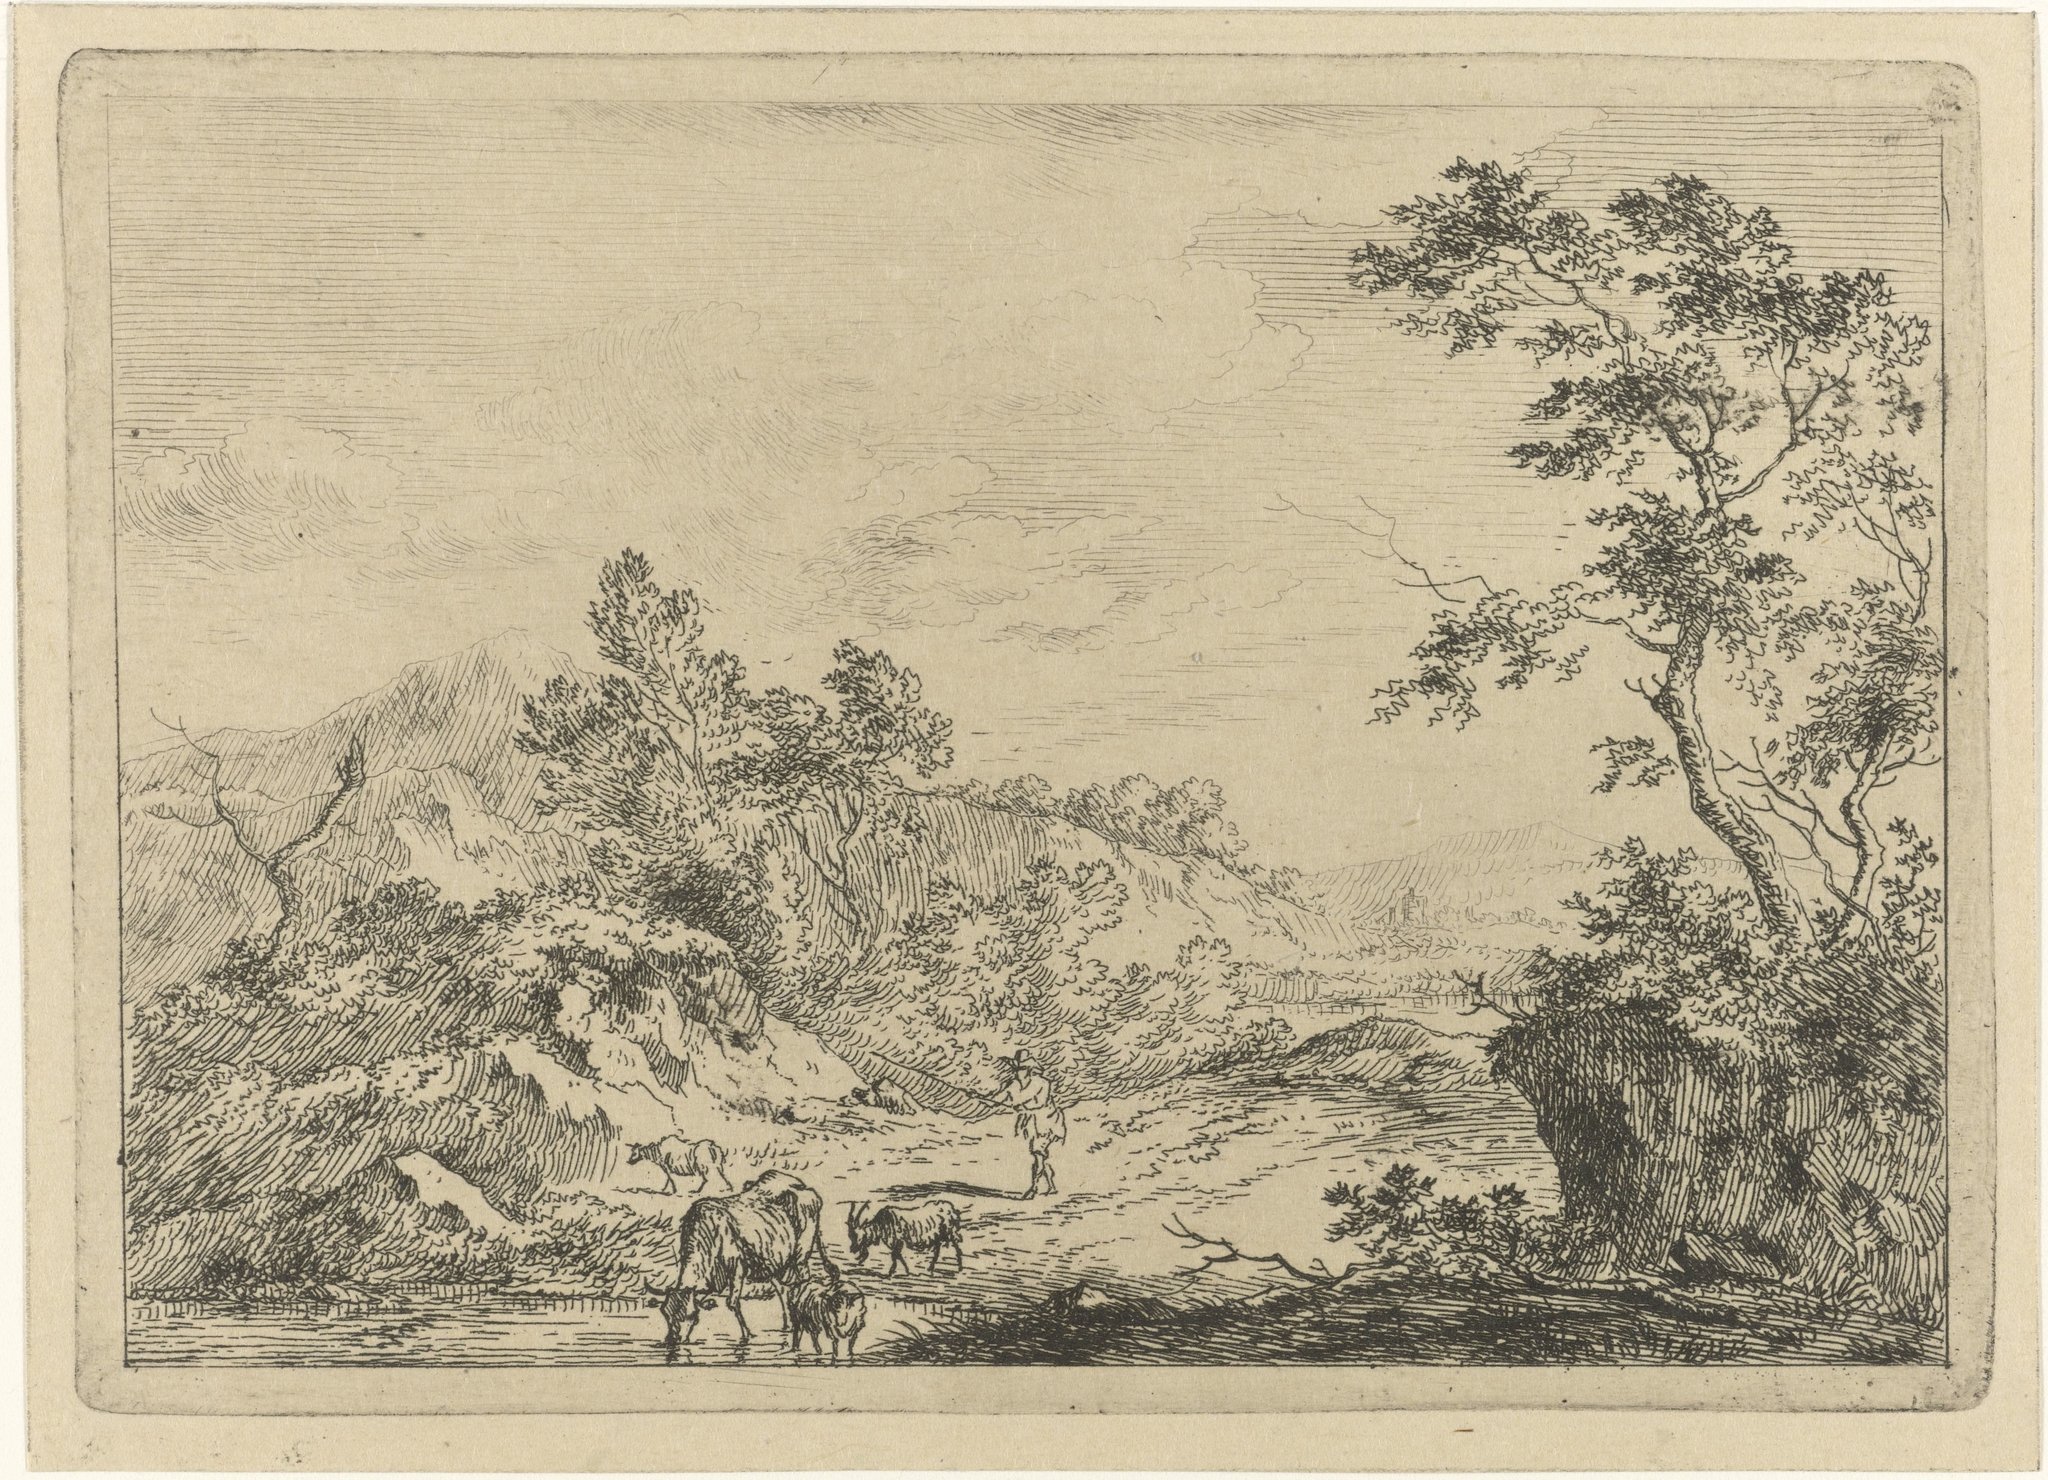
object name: print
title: Landschap met herder en vee bij beek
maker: johannes janson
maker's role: draughtsman, painter, print maker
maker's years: 1729-1784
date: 1761-1784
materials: paper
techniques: etching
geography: leiden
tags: herding, herdsman, herdswoman, shepherd, shepherdess, cowherd, etc., landscapes (+ landscape with figures, staffage)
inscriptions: collector's mark: Lugt 240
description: Heuvelachtig landschap met een herder, die zijn vee naar een beekje drijft om te drinken. Prent uit een serie met landschappen.